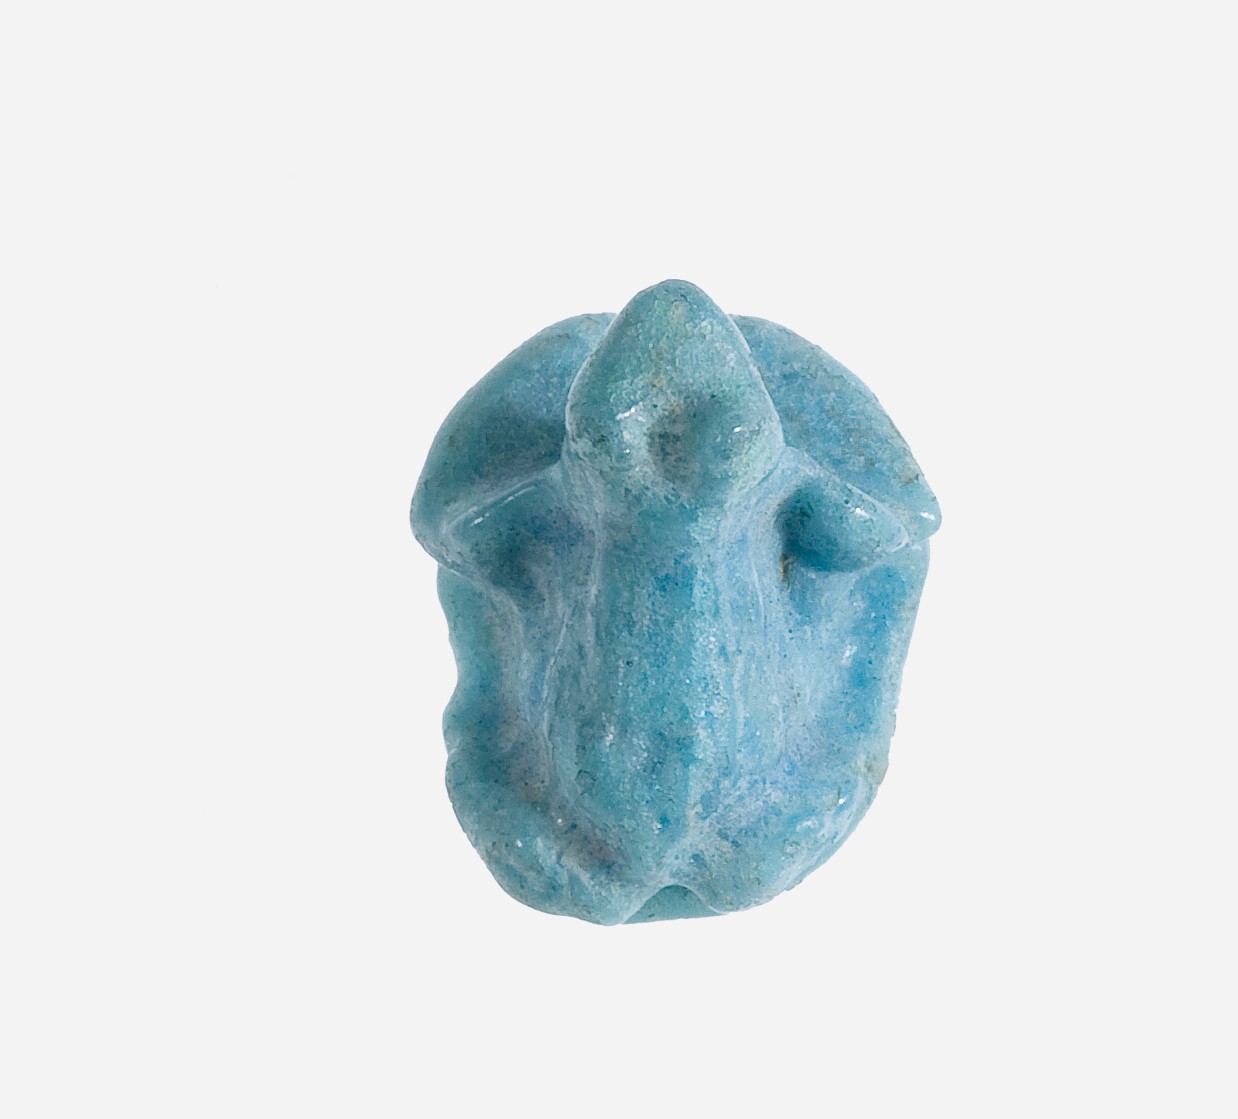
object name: seal amulet, frog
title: Frog Seal Amulet with the Throne Name of Amenhotep III on the Base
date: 1390-1352 BCE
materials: faience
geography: egypt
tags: frogs